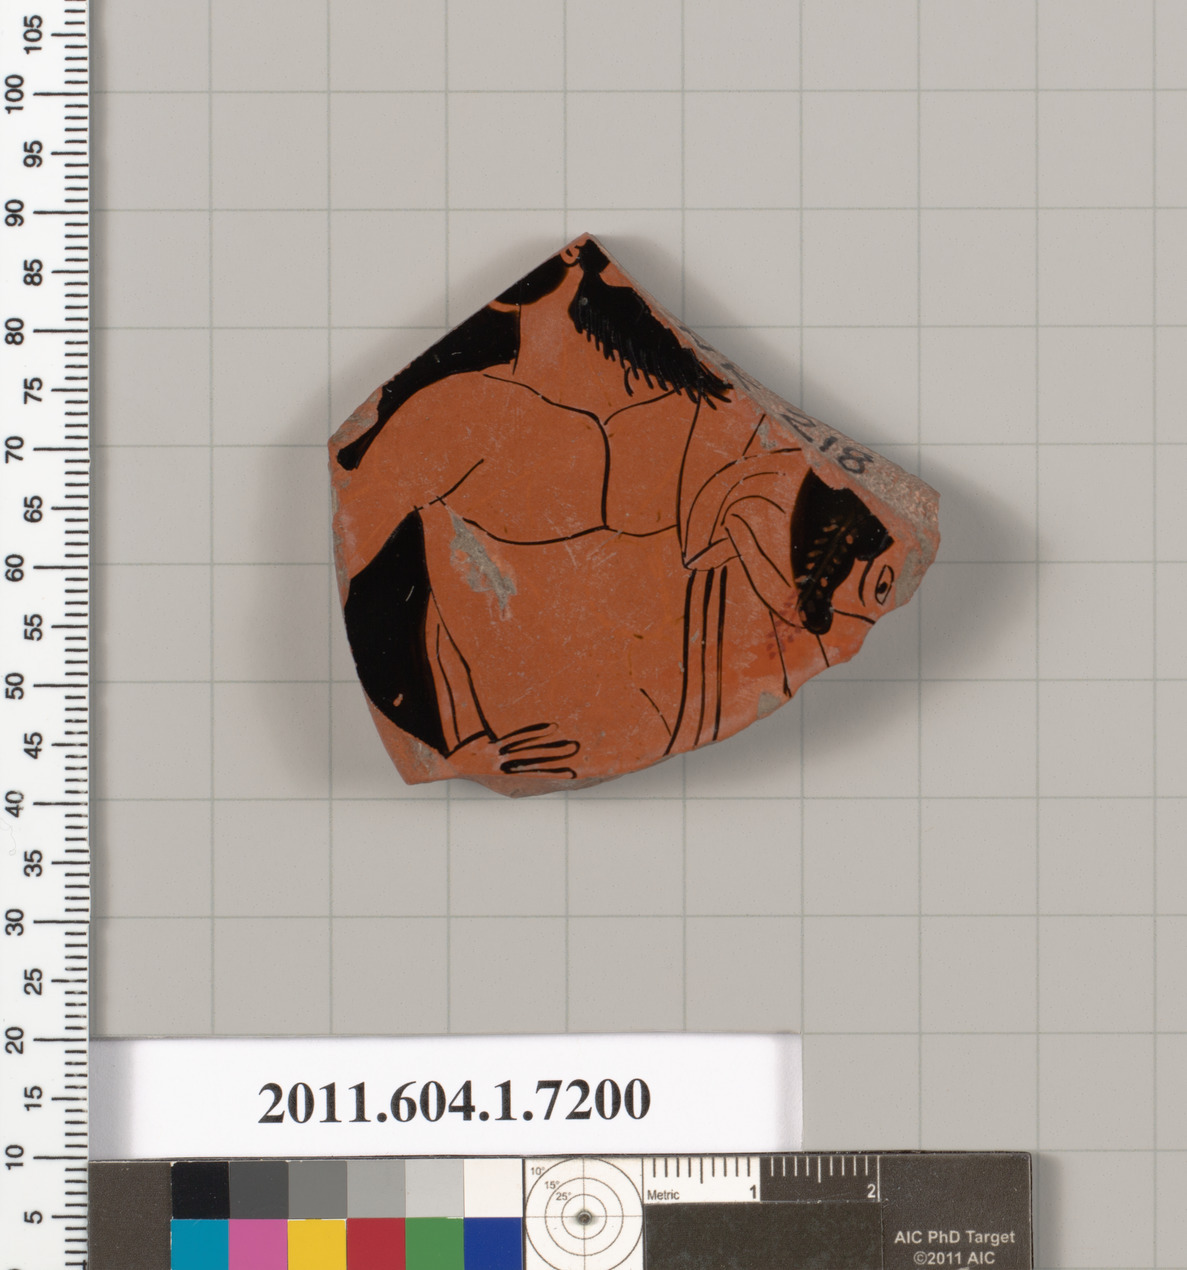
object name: kylix fragment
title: Terracotta fragment of a kylix (drinking cup)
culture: greek, attic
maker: makron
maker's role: artist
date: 500-480 BCE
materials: terracotta